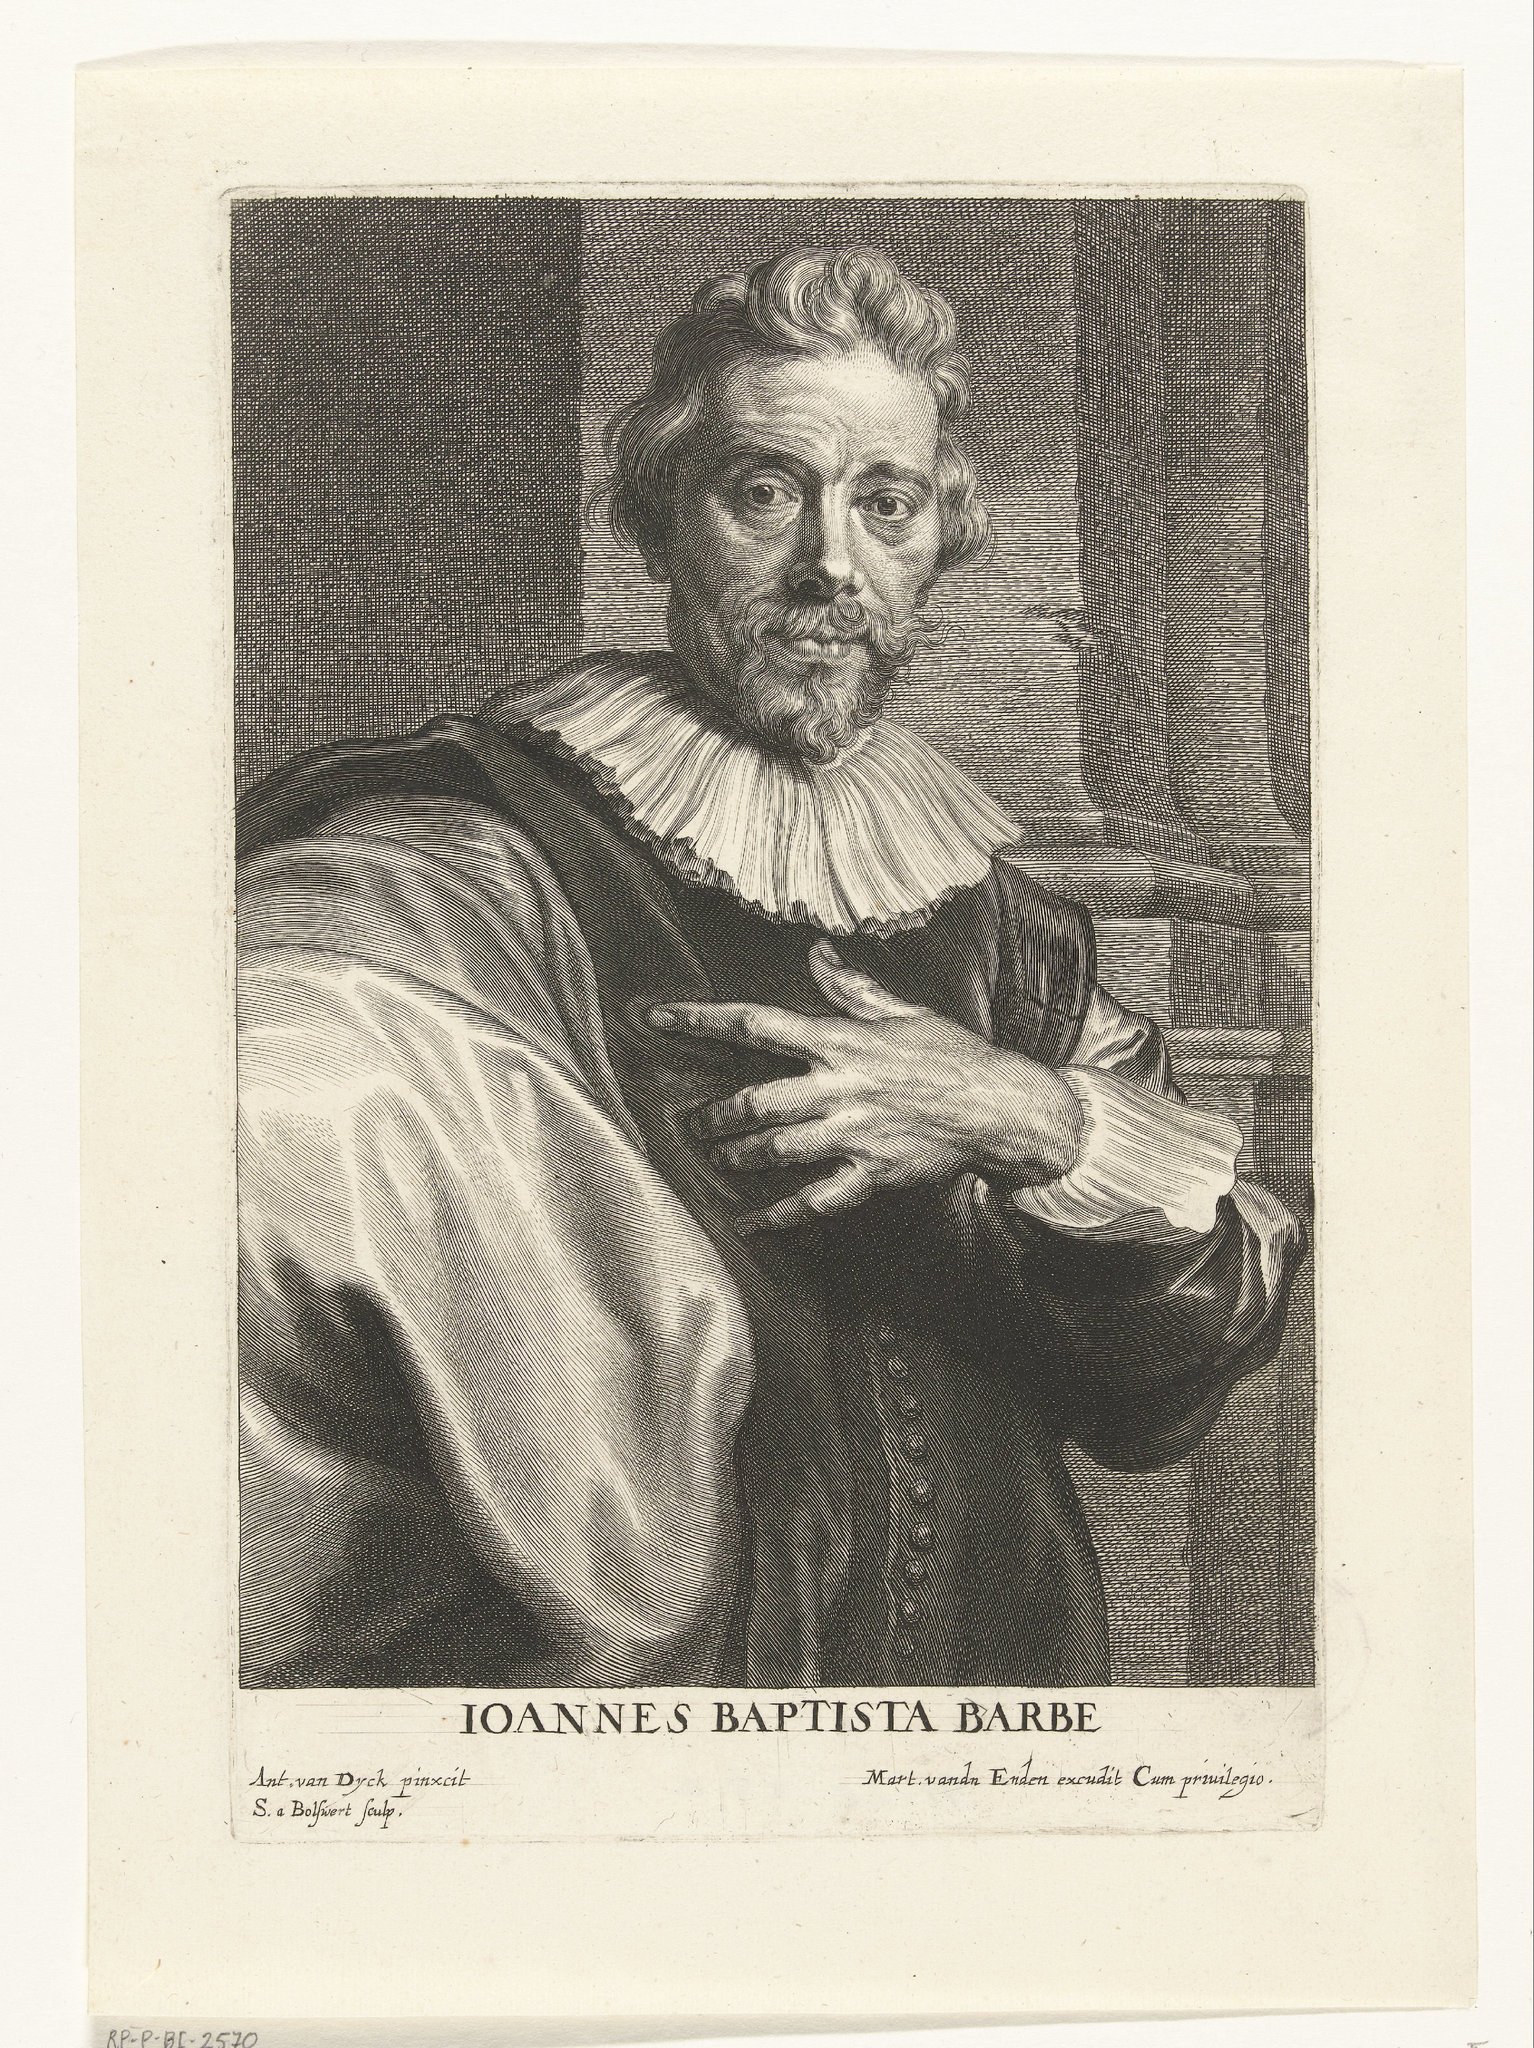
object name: print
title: Portret van Jean Baptiste Barbé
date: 1596-1659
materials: paper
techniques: engraving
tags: antwerp, print maker, jan-baptist barbé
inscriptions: collector's mark: Lugt 240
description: Prent naar schilderij van Anthony van Dyck